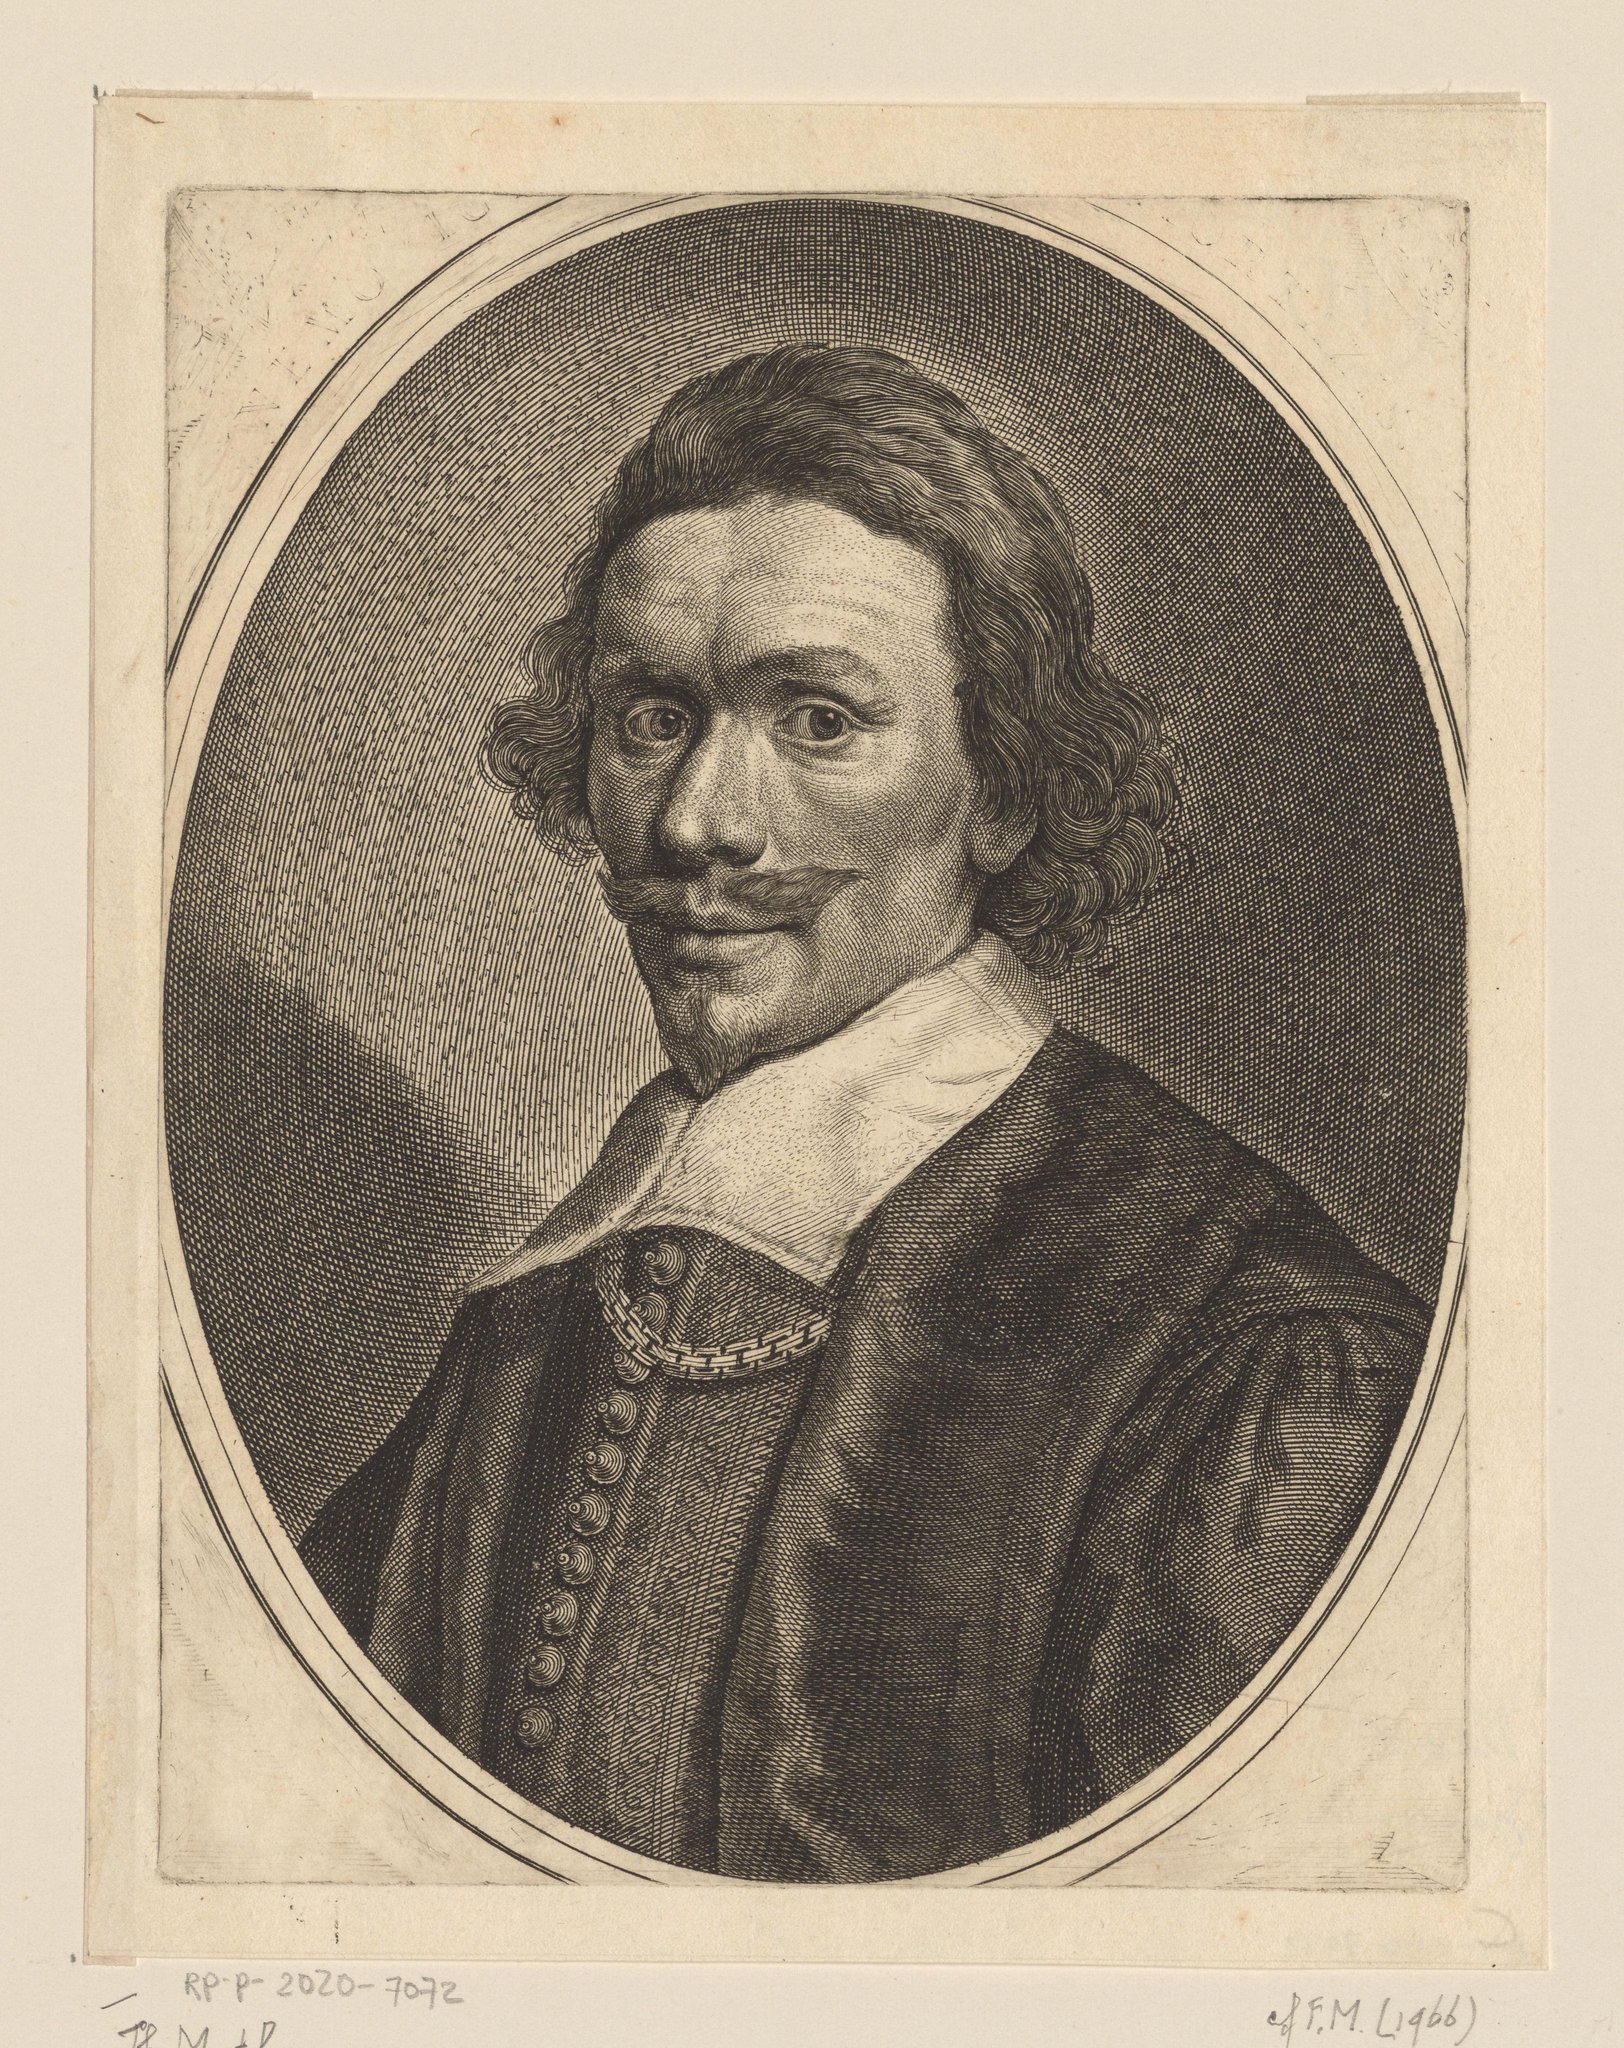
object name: print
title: Portret van Theodorus Johannes Dirk Graswinckel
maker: theodor matham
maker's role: draughtsman, print maker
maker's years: 1605-1676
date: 1636-1666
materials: paper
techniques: engraving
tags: delft, mechelen, theodorus johannes dirk graswinckel, historical persons, writer, poet, author